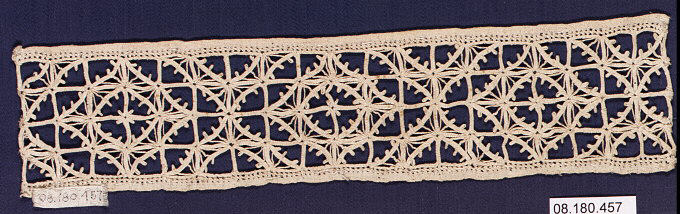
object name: border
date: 1601-1700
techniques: lace